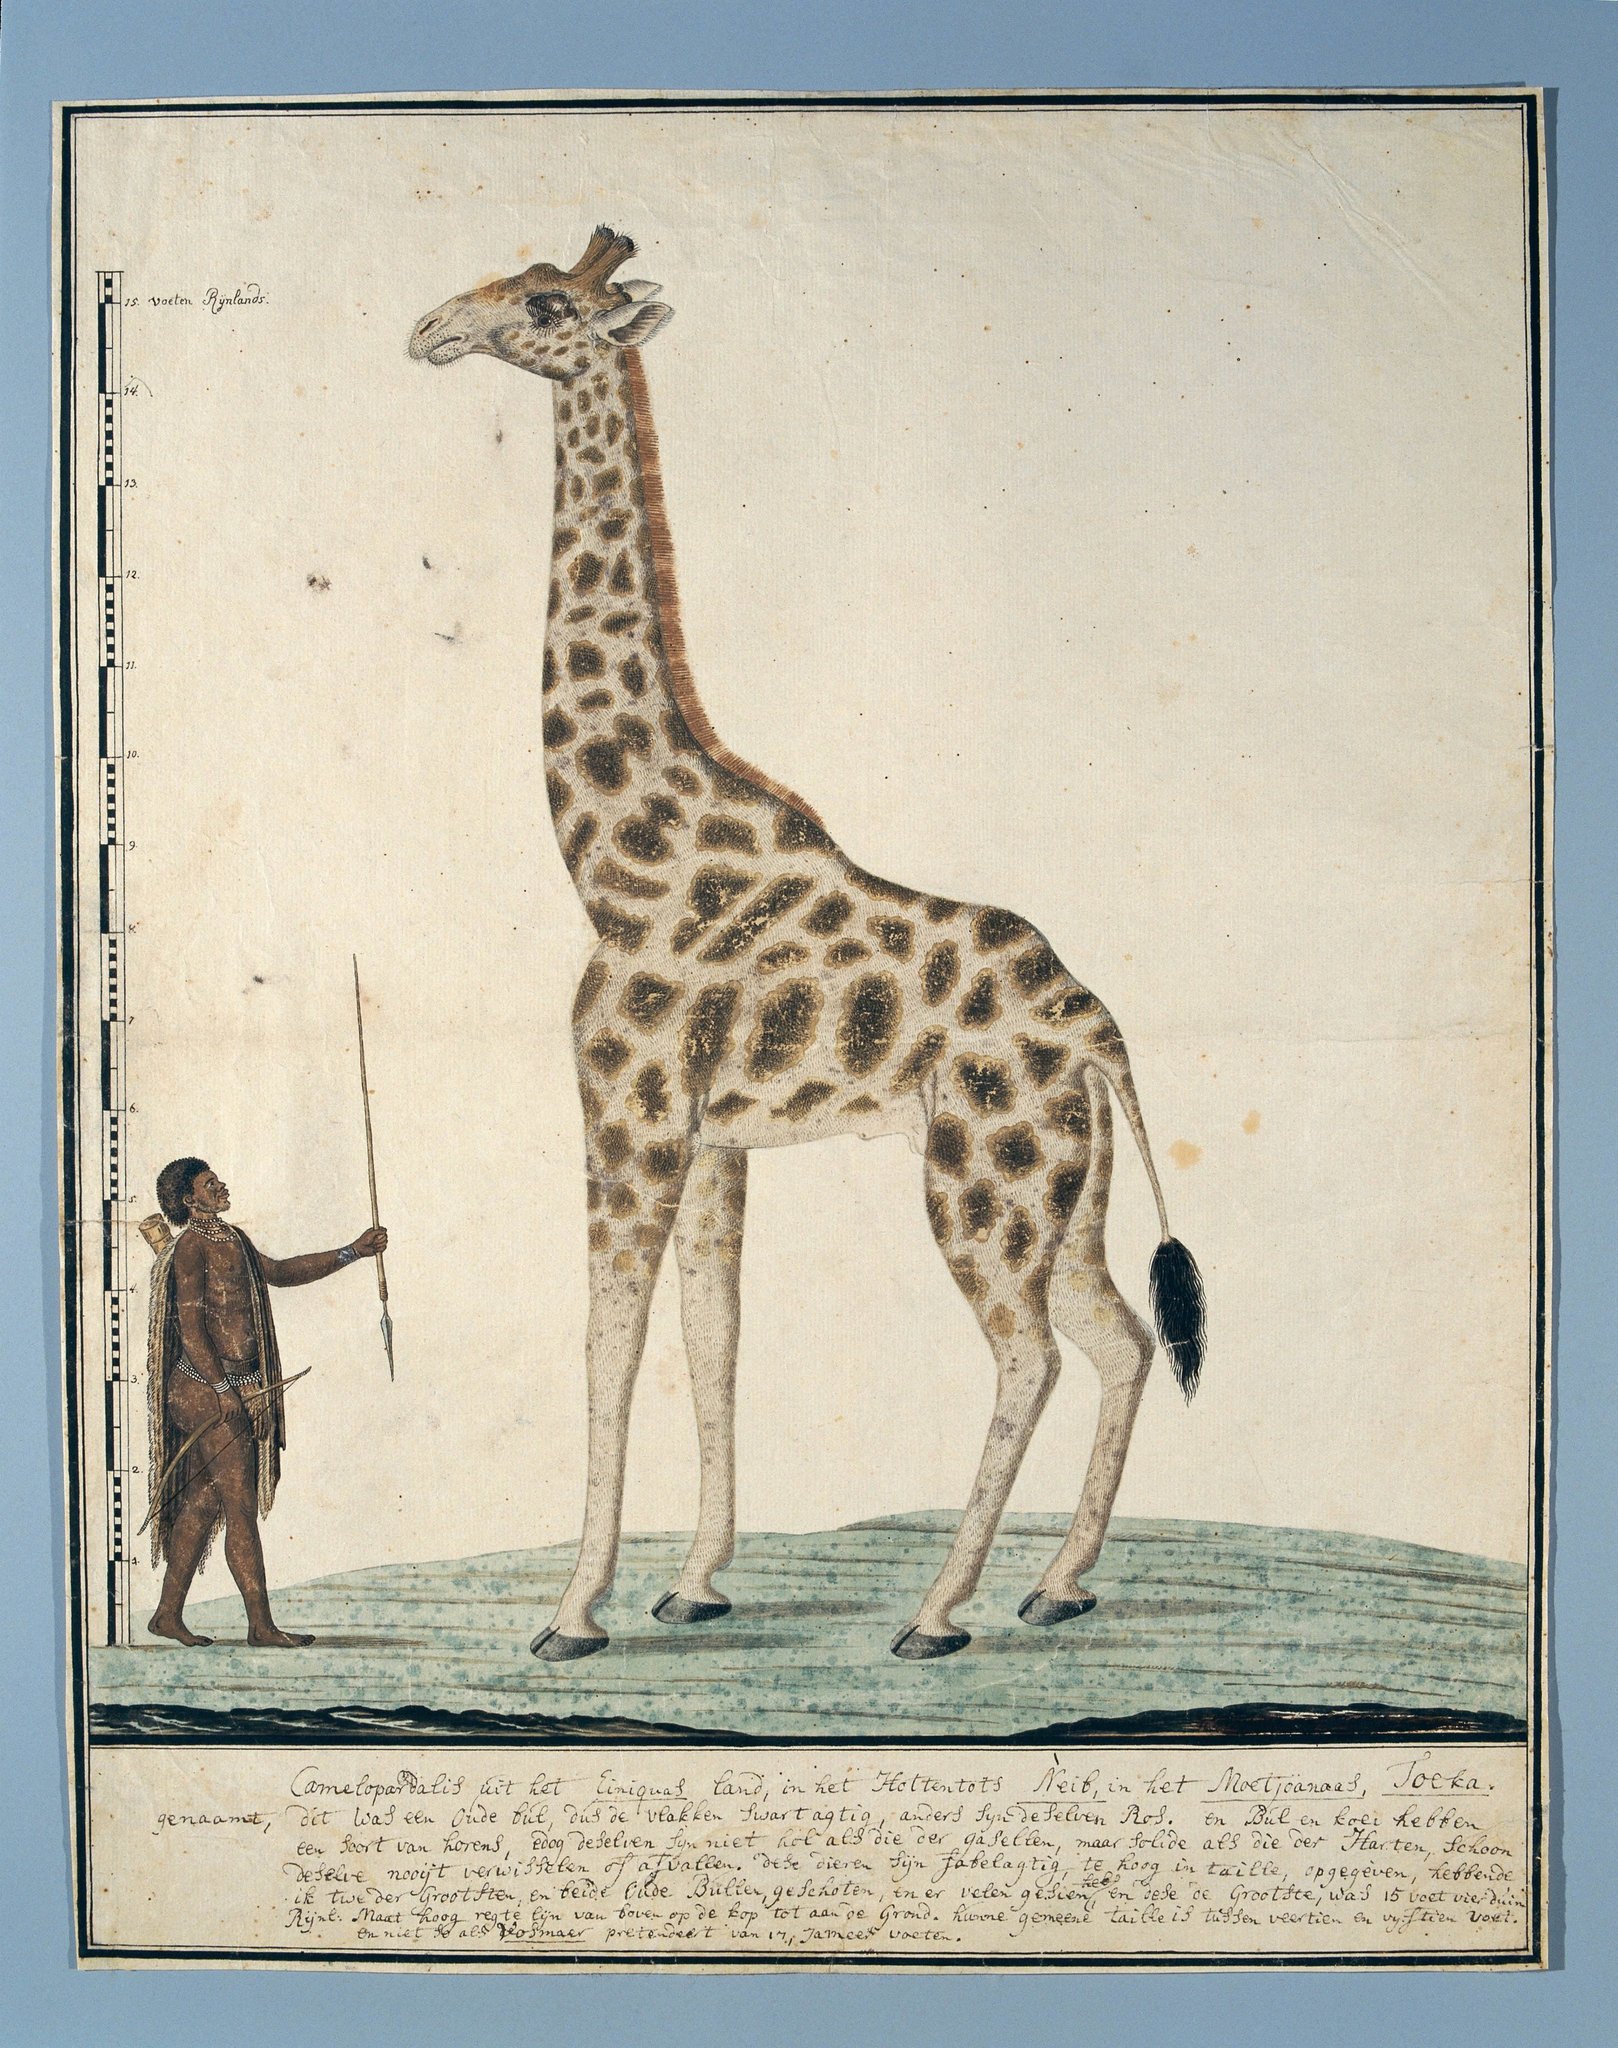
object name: drawing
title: Giraffa camelopardalis (Giraffe)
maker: robert jacob gordon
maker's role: draughtsman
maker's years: 1743-1795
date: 1779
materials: paint, ink, paper, pencil, watercolor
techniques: brush, pen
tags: hoofed animals: giraffe (+ skeleton of an animal), khoikhoi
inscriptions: annotation: ‘recto links: schaalverdeling [...]. voeten Rijnlands. ; onder: Camelopardalis....’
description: Giraf (Giraffa camelopardalis), met schaalverdeling in Rijnlandse maat; de Khoikhoi houdt zijn assegaai als meetlat omhoog.